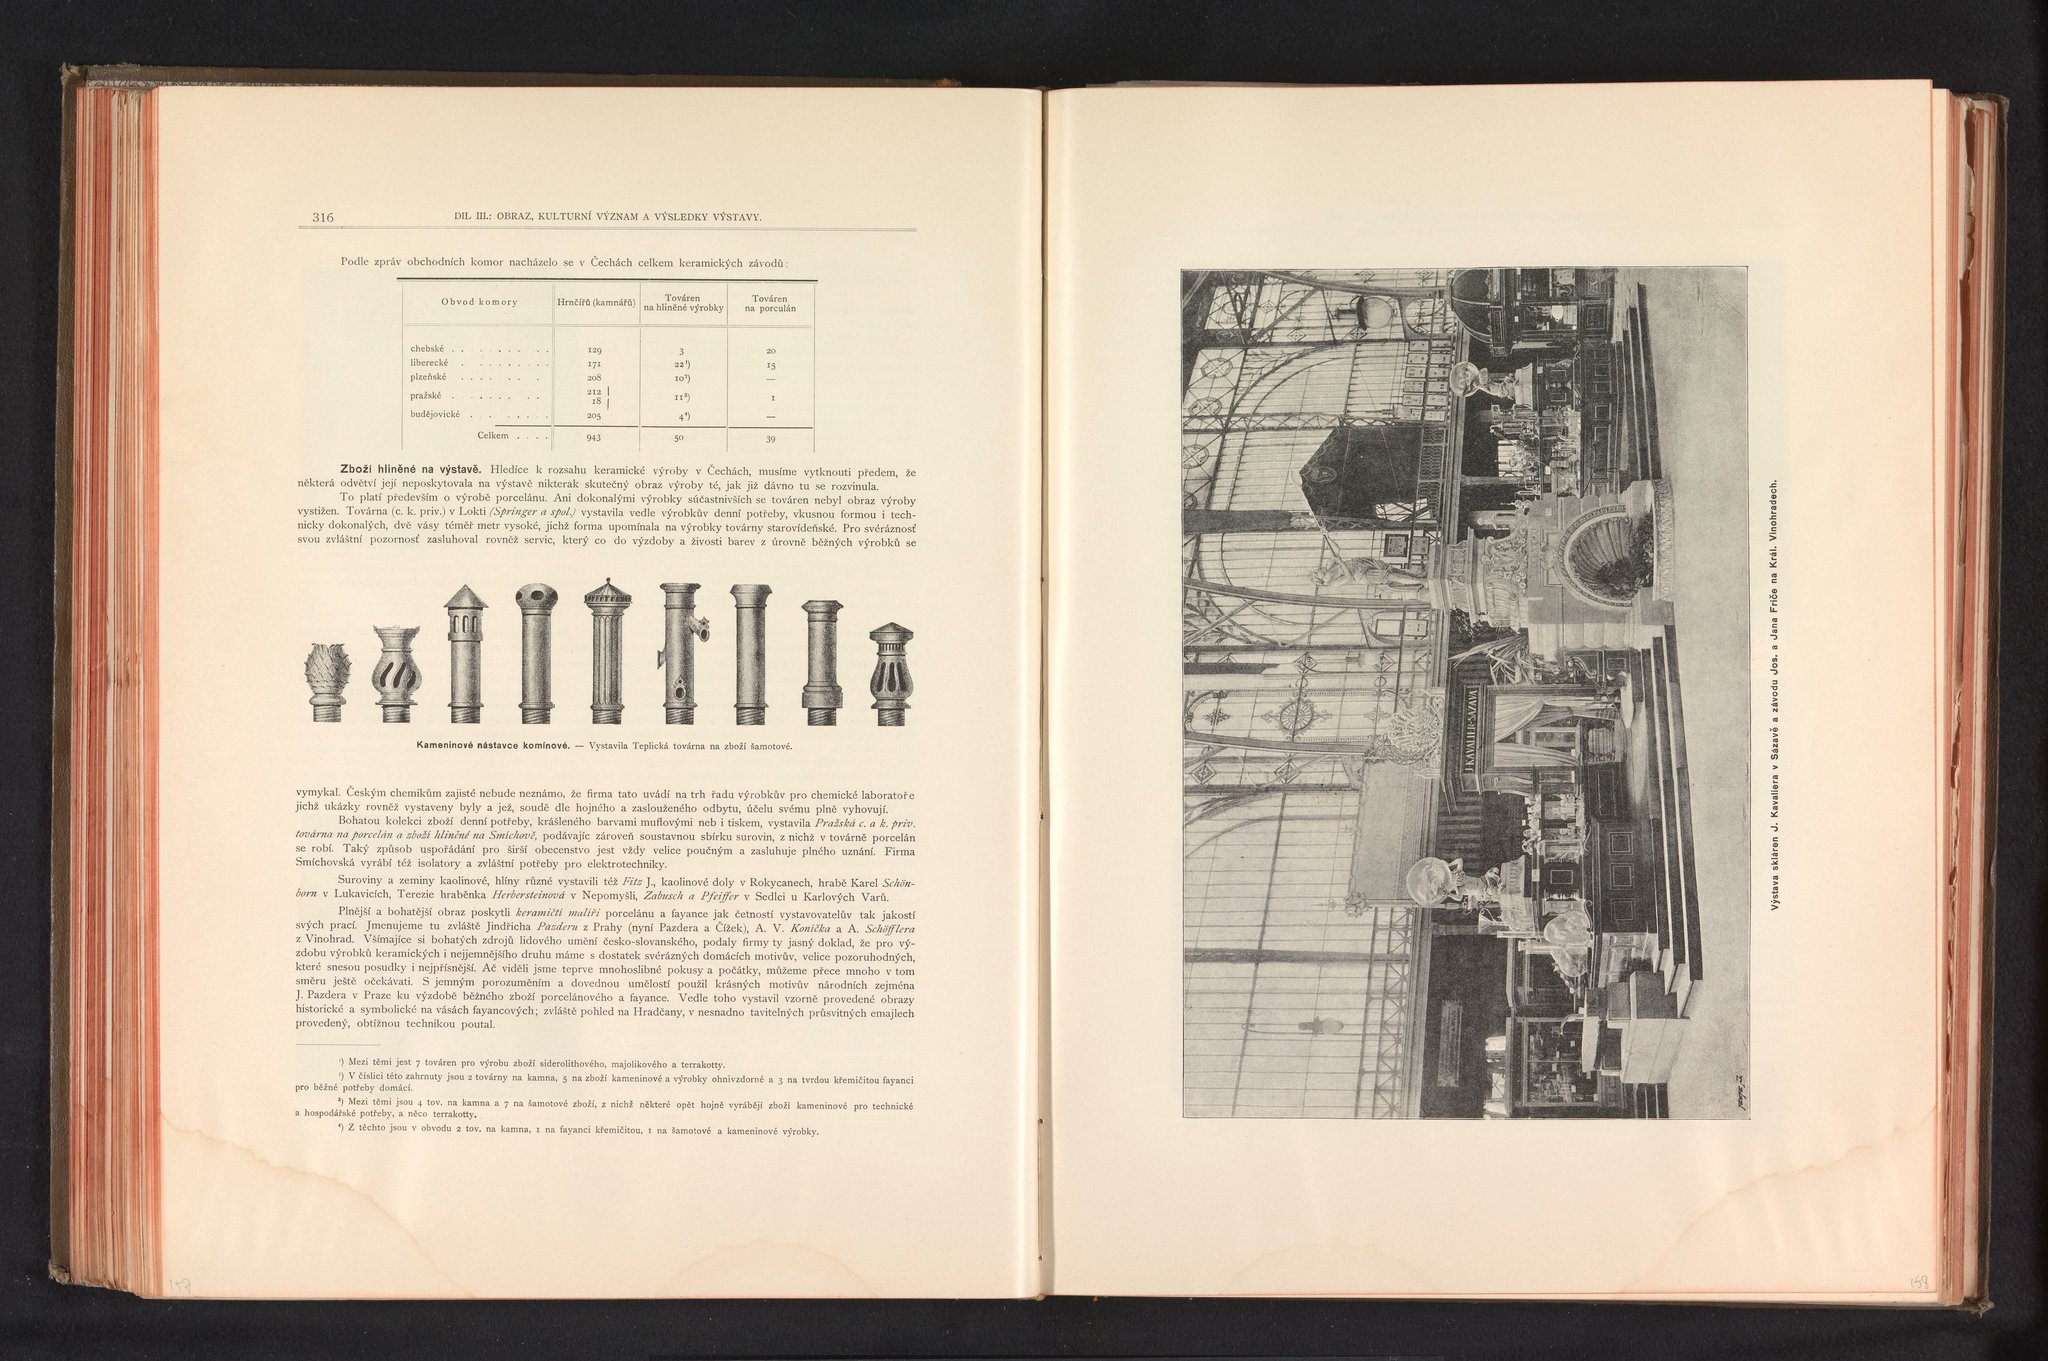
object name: page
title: Kameninové nástavce kominové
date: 1890-1895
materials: paper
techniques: autotype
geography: prague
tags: chimney